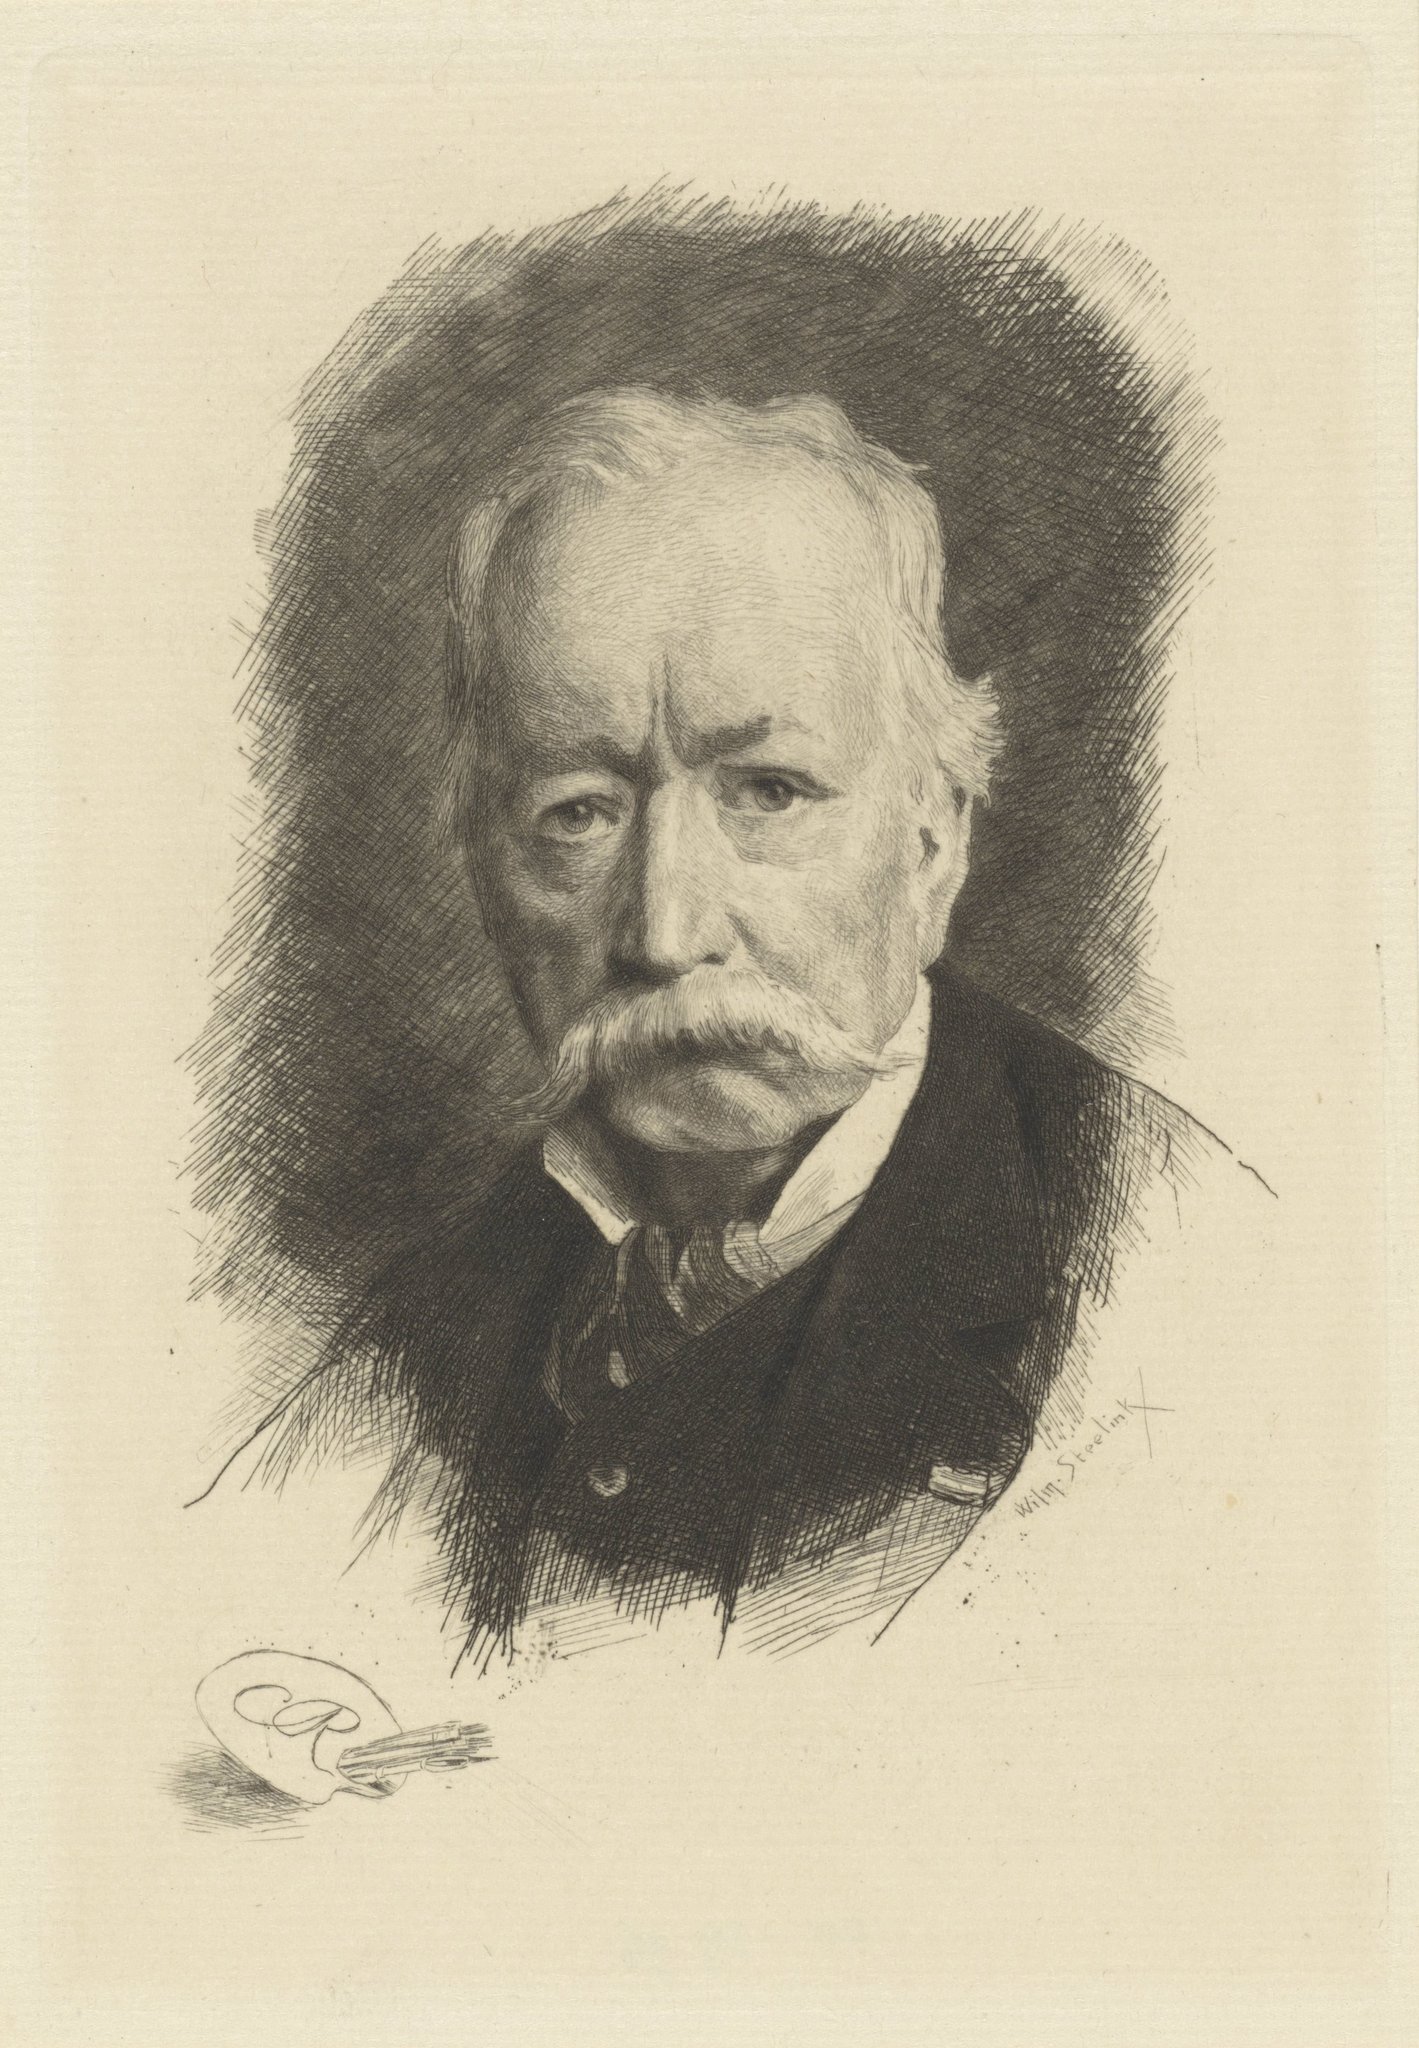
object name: print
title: Portret van Charles Rochussen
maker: willem steelink (ii)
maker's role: draughtsman, print maker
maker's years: 1856-1928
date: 1866-1928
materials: paper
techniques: etching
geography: netherlands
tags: rotterdam, painter, print maker, draughtsman, charles rochussen, portrait, self-portrait of painter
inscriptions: collector's mark: Lugt 2228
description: Portret van de kunstenaar Charles Rochussen. Linksonder zijn monogram op een palet met penselen.